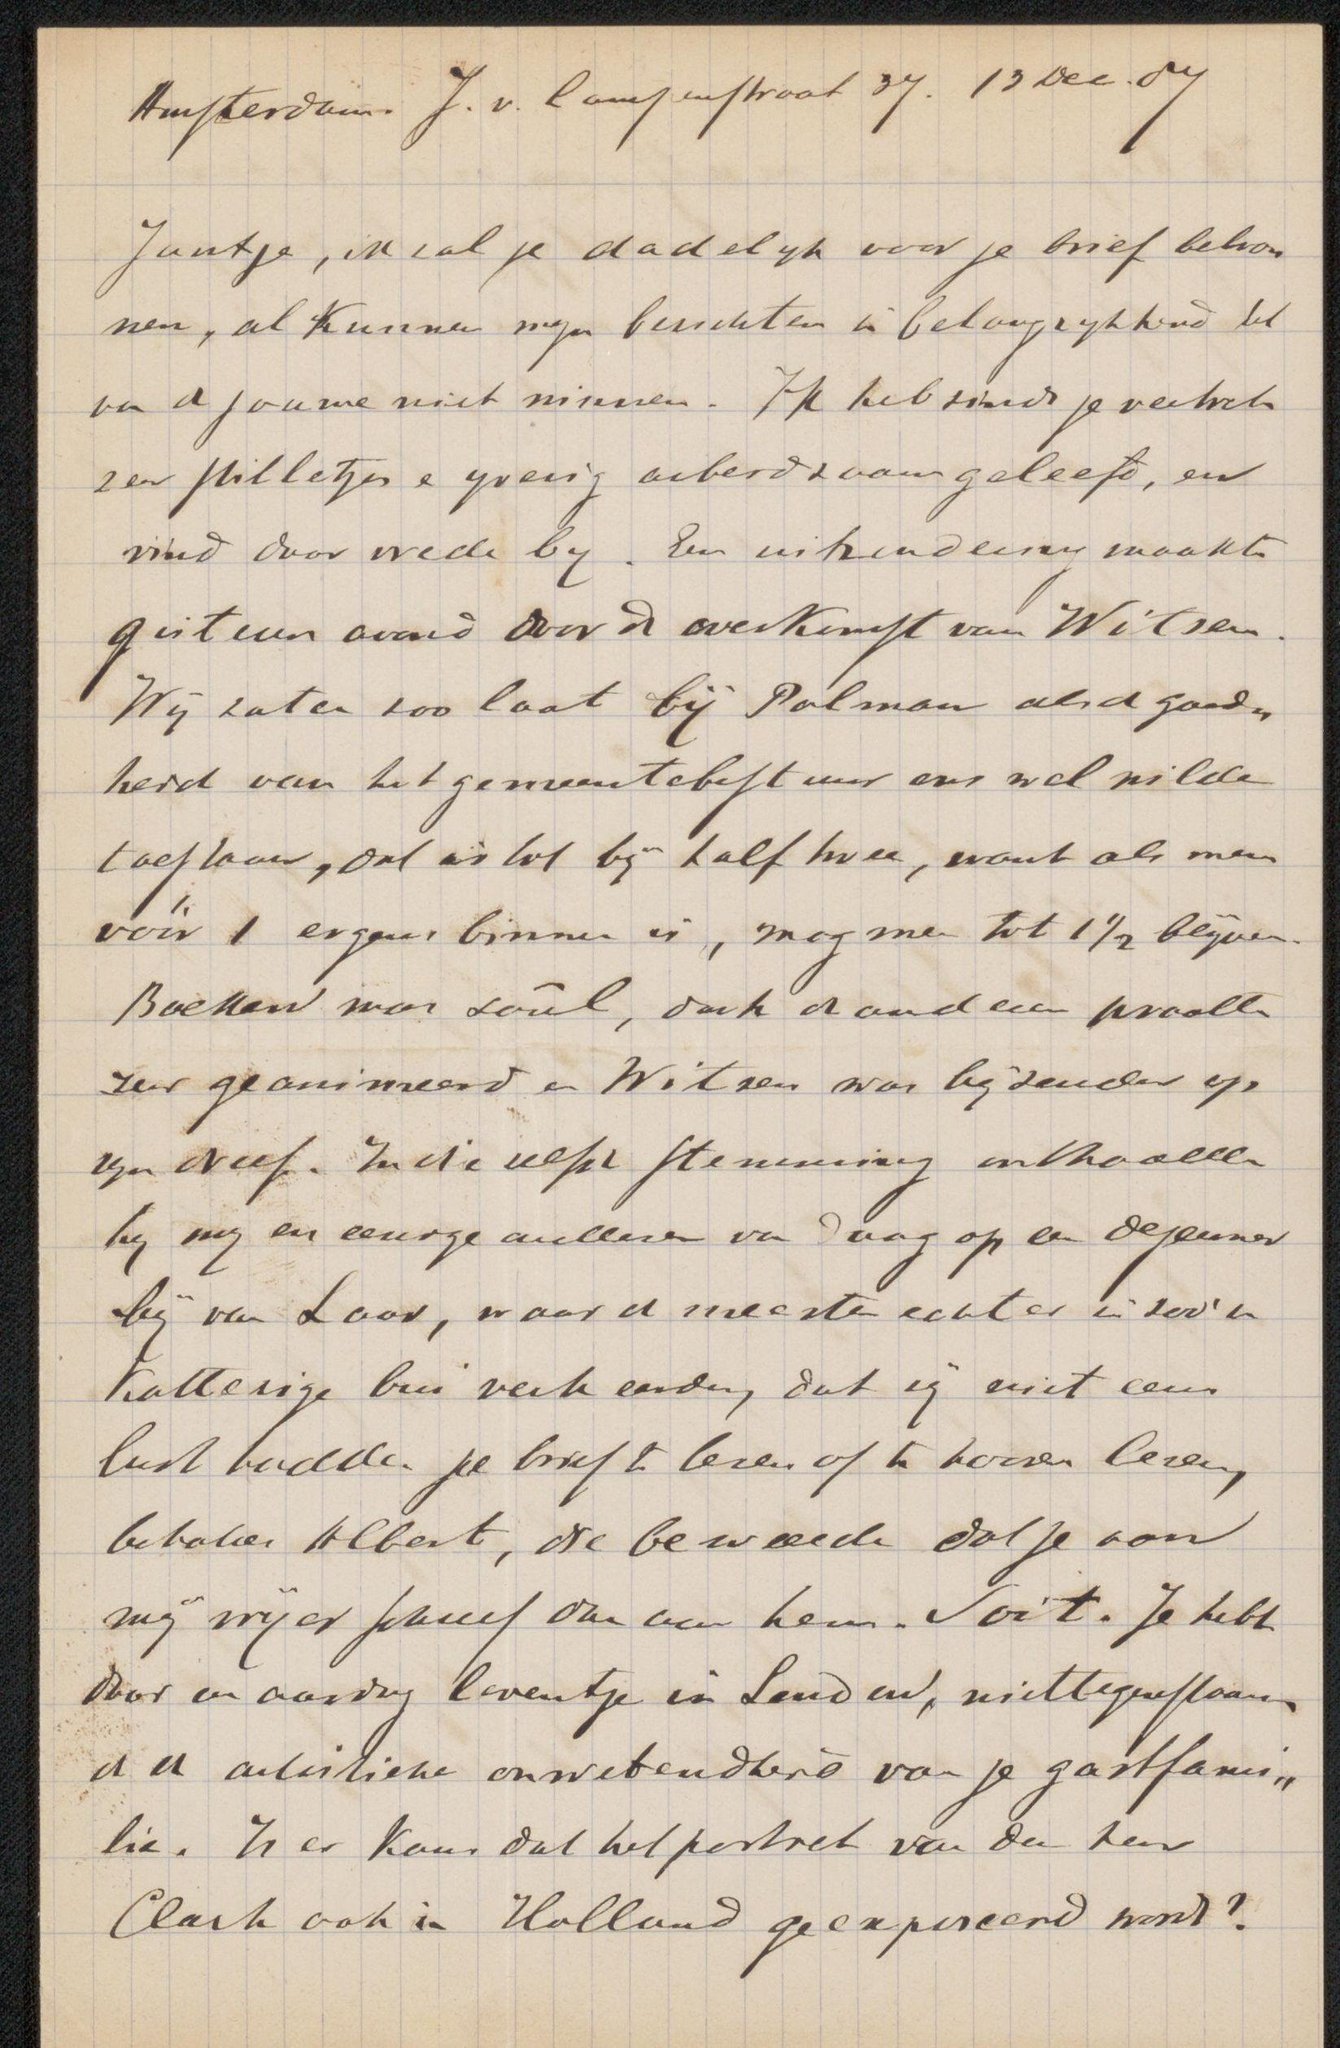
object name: letter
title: Brief aan Jan Veth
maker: chap van deventer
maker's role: kunstcriticus, scheikundige, schrijver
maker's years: 1860-1931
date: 1887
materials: ink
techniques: pen, writing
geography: amsterdam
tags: rotterdam, george hendrik breitner, jan veth, amsterdam, painter, print maker, draughtsman, willem witsen, frederik van eeden, albert verwey, hein boeken, historical persons (portraits and scenes from the life), money, london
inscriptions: collector's mark: ‘RPK’